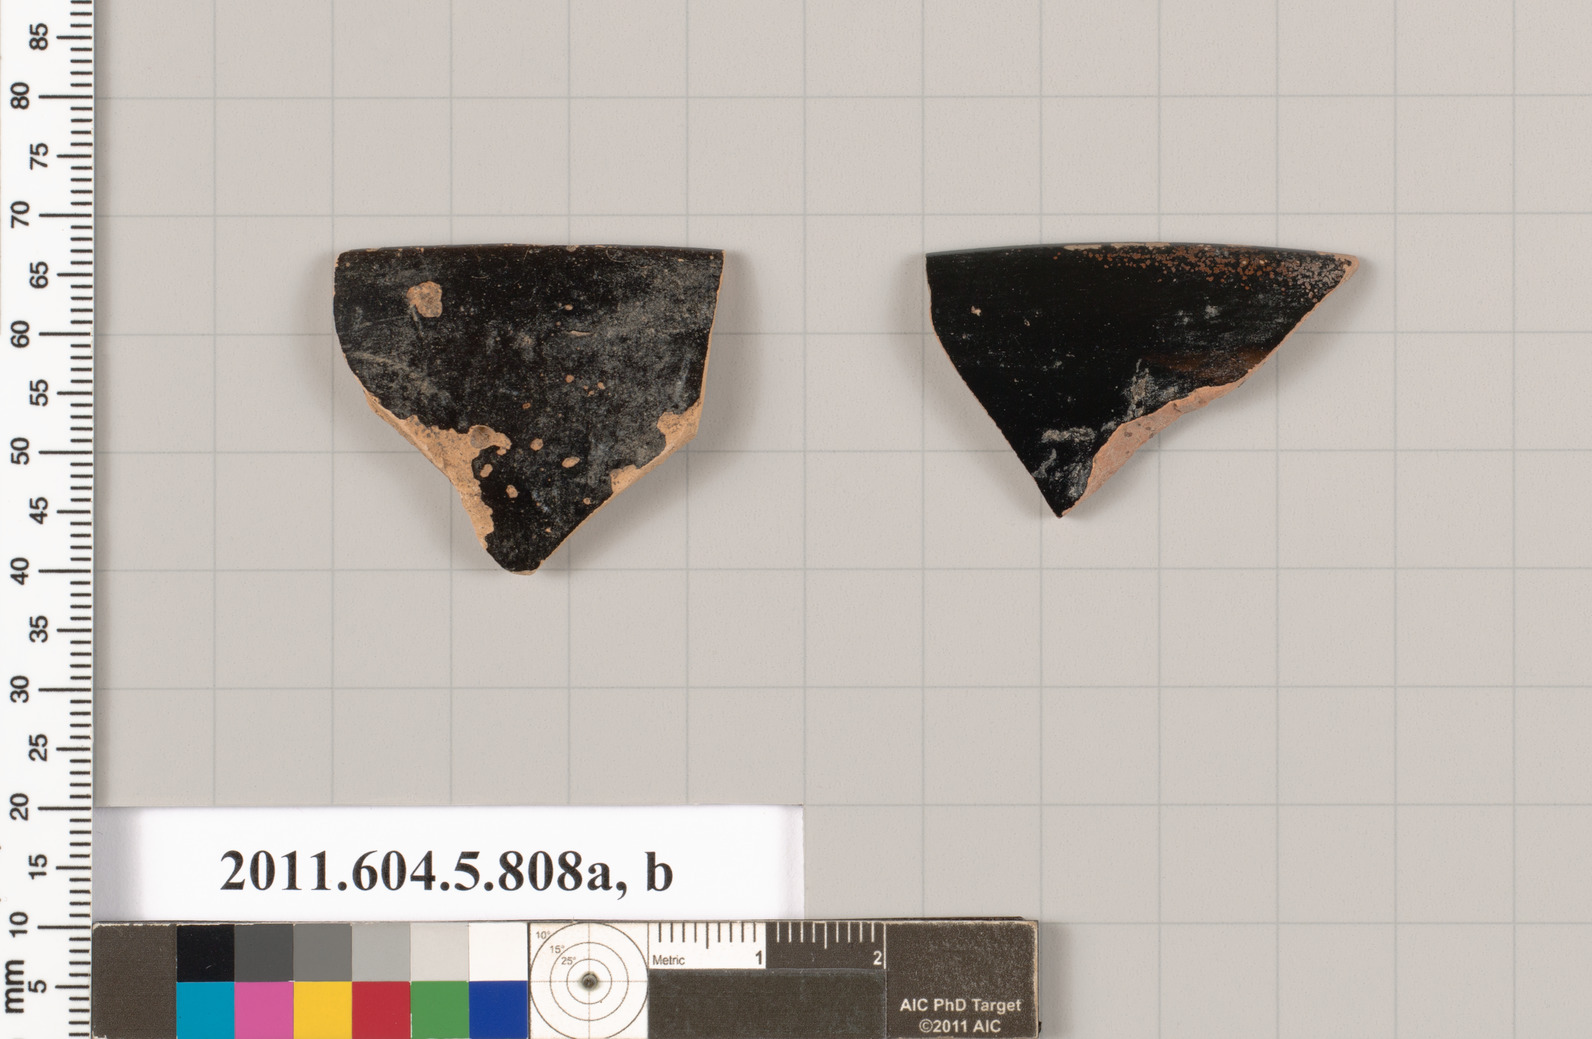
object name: kylix fragment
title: Terracotta rim fragments of kylikes (drinking cups)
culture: greek, attic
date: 600-401 BCE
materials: terracotta